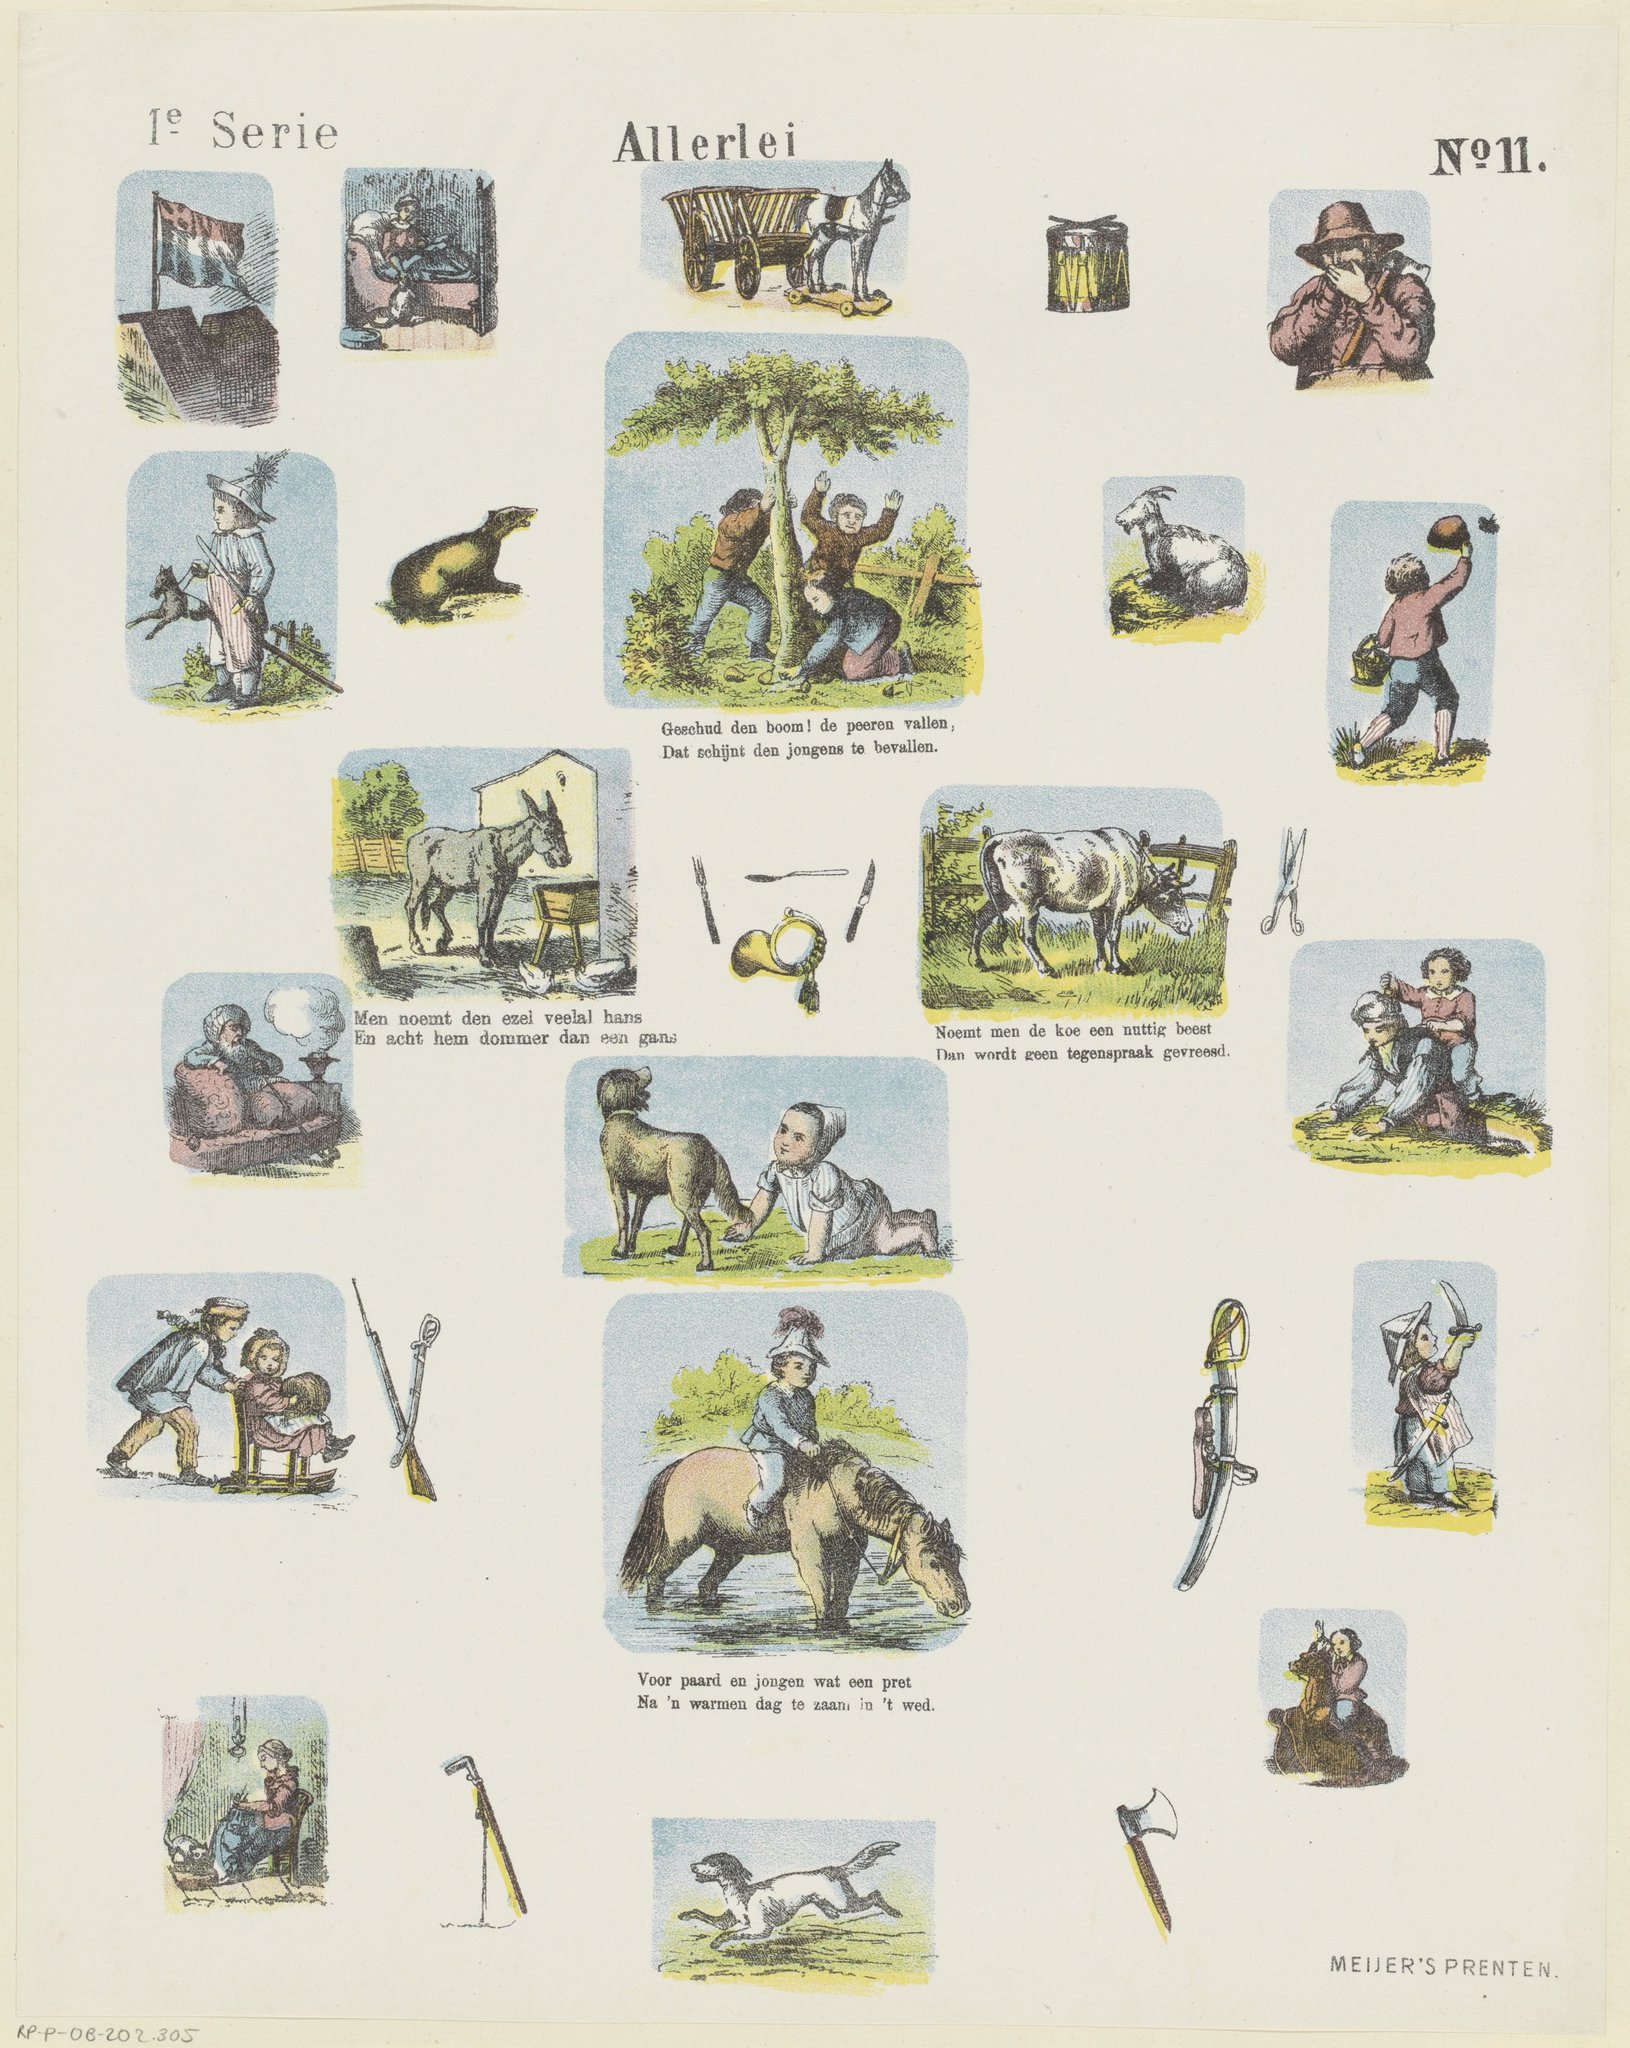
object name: print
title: Allerlei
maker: Anonymous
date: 1873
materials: paper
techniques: lithograph, letterpress printing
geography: amsterdam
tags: animals, weapons, characters (human types), child playing with animals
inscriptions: collector's mark: Lugt 2760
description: Blad met 27 voorstellingen van verschillende dieren, voorwerpen en figuren. Onder enkele afbeeldingen een onderschrift. Genummerd rechtsboven: No. 11.